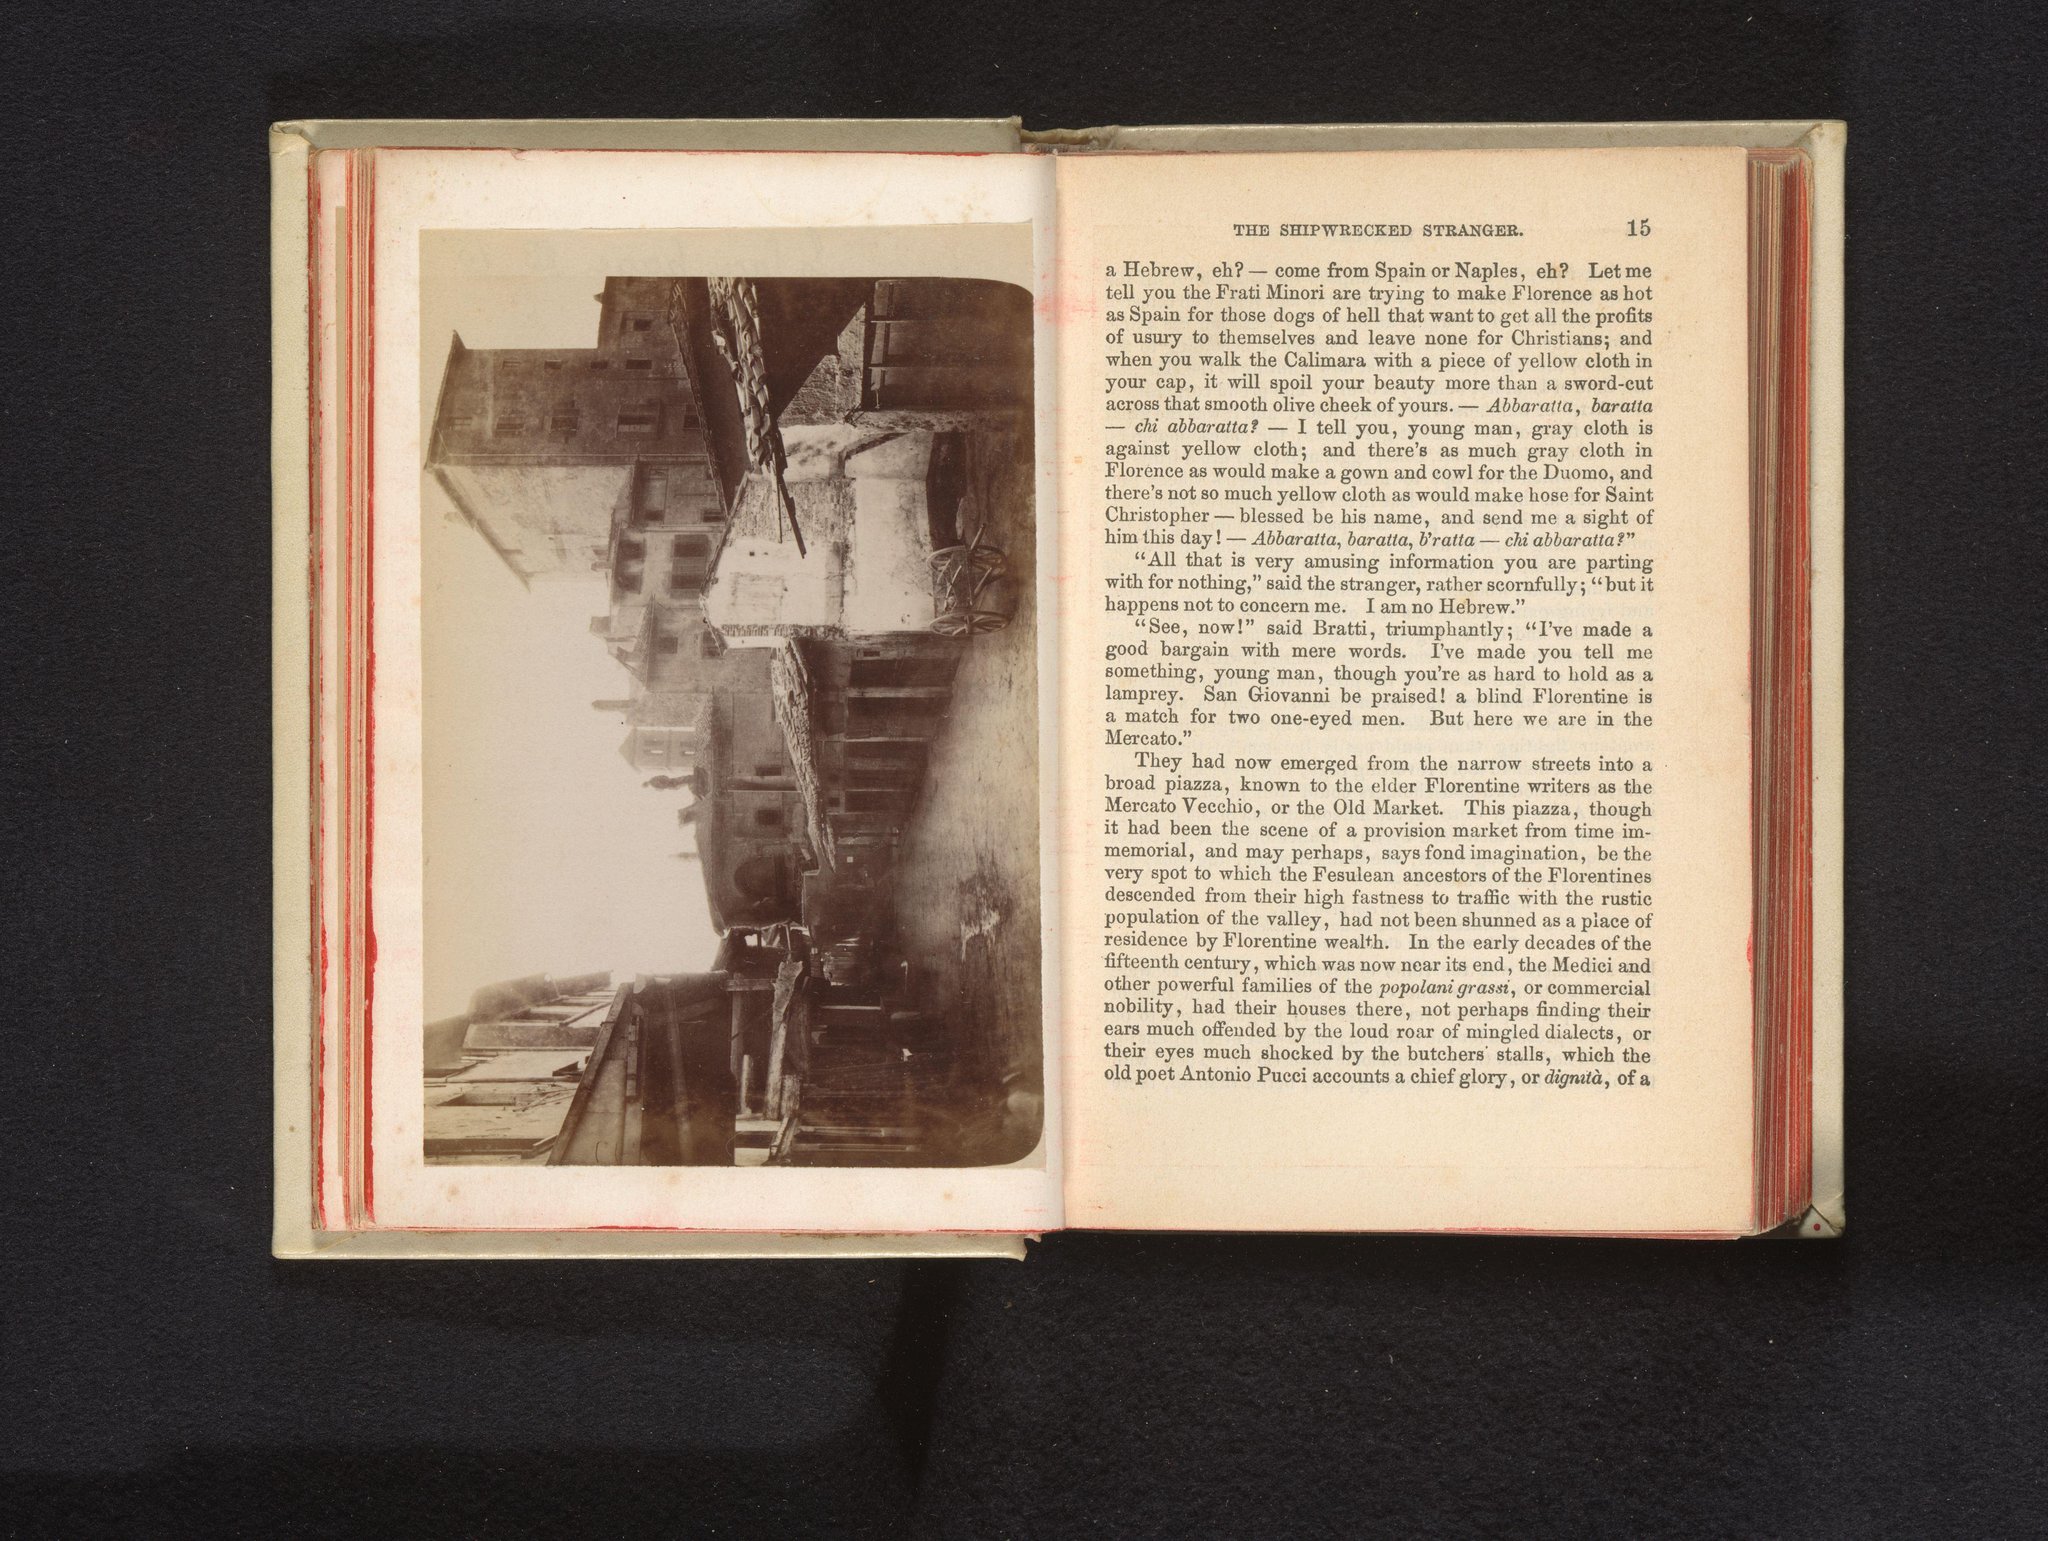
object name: photograph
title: Piazza del Mercato Vecchio te Florence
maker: Anonymous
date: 1858-1863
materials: photographic support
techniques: albumen print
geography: florence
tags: market, façade (of house or building)